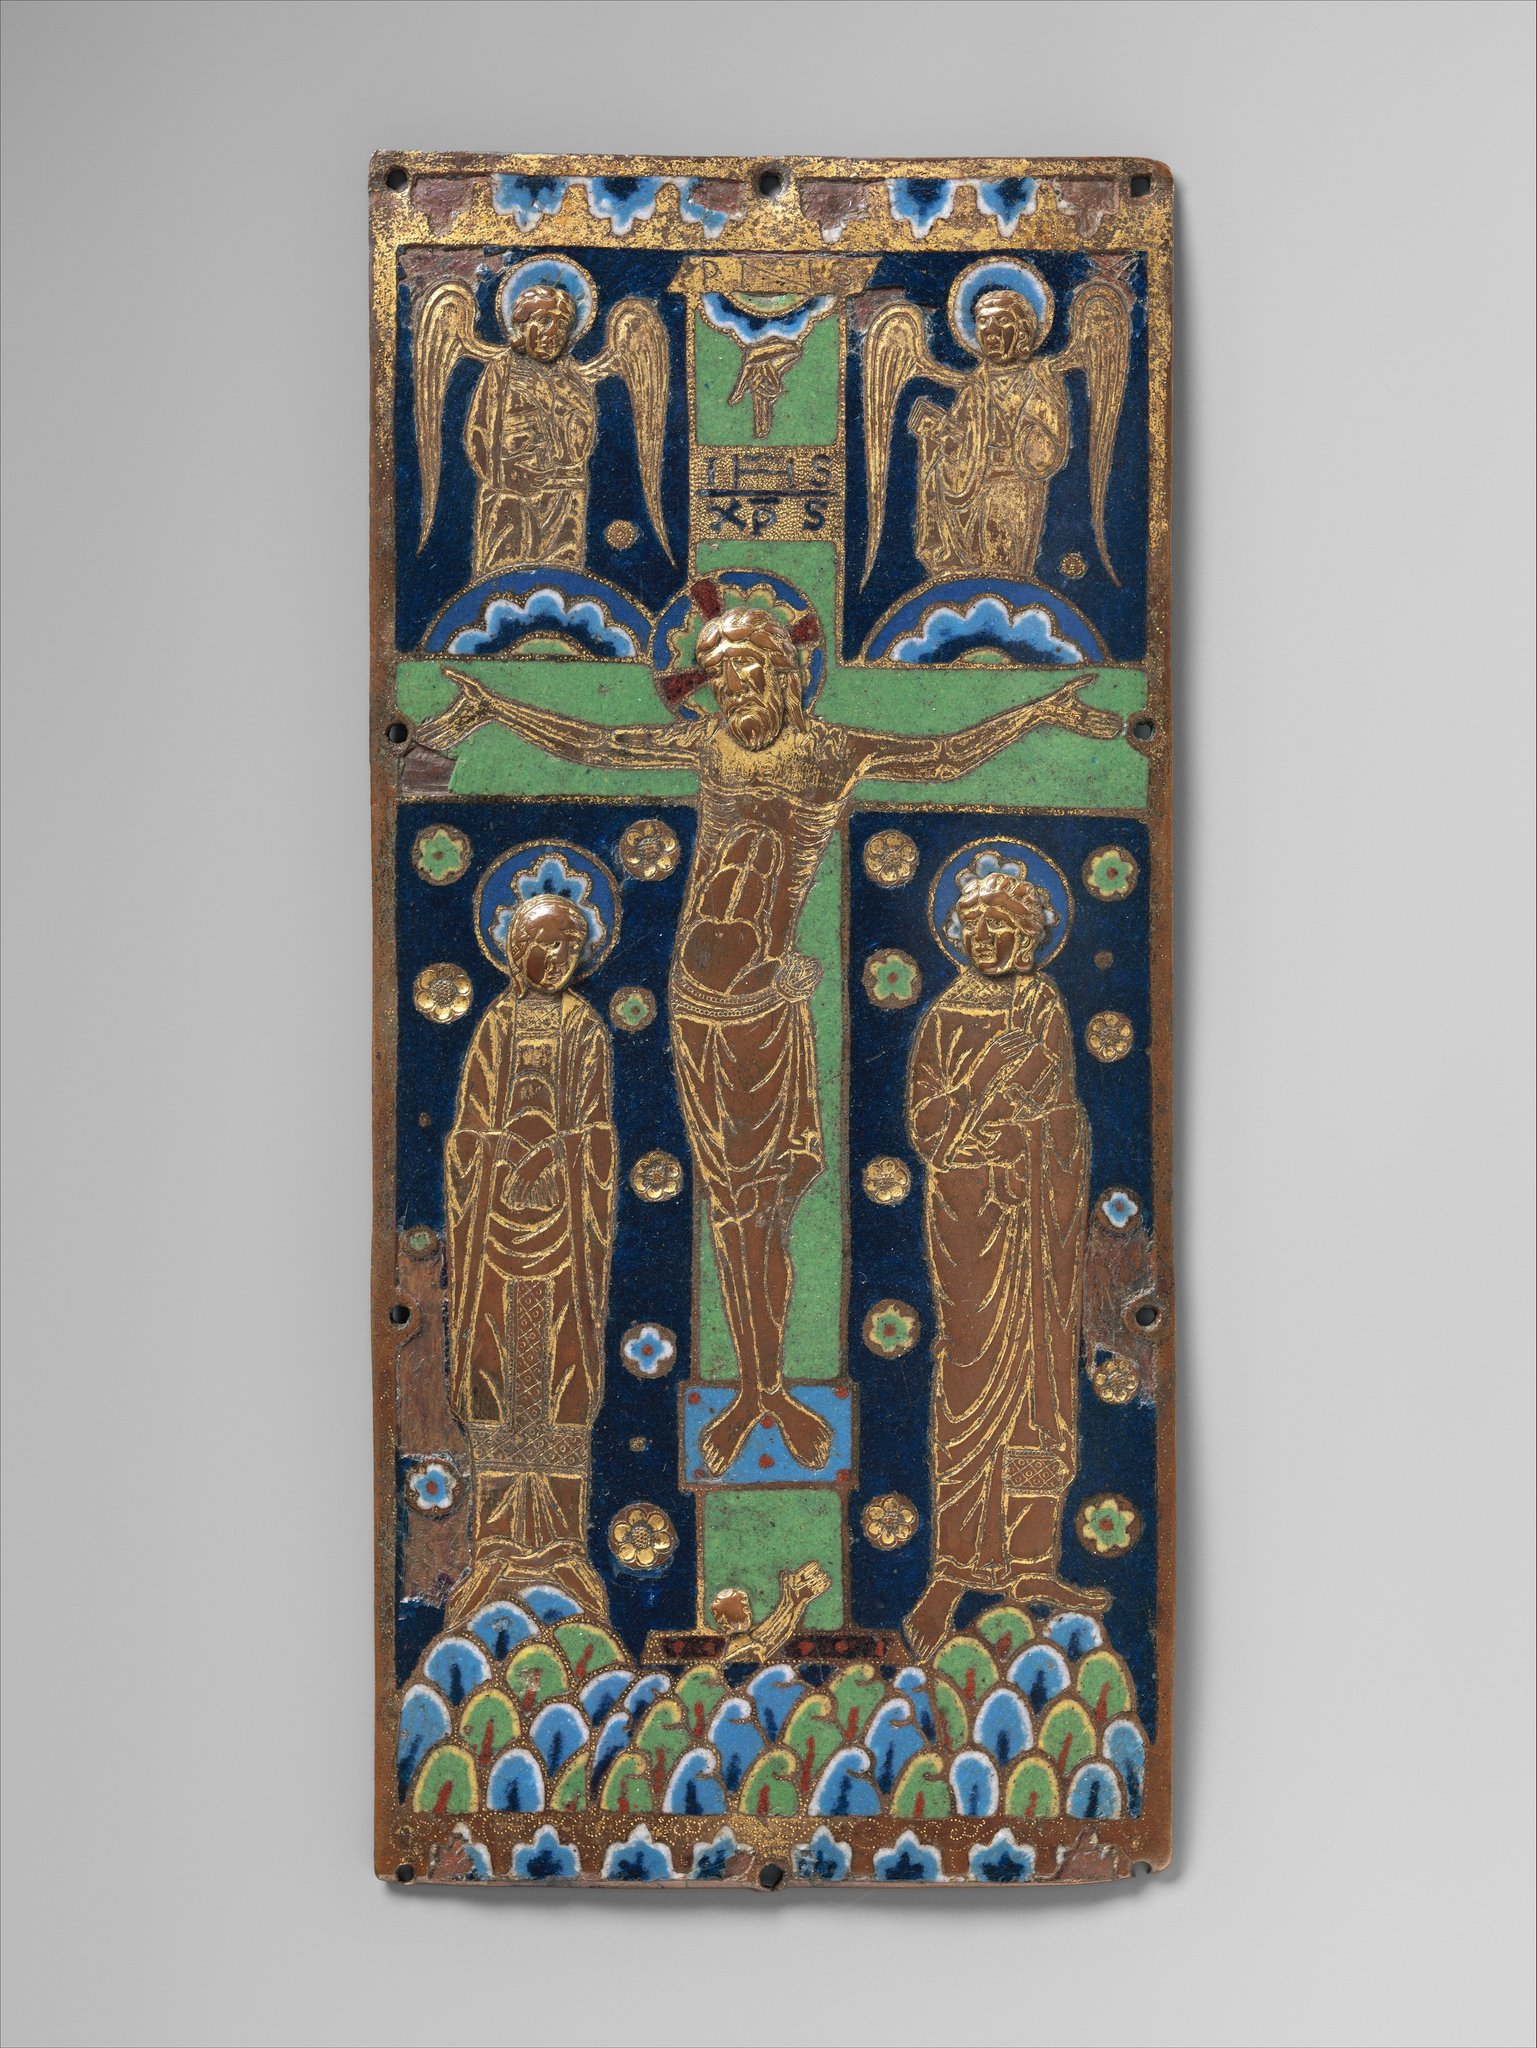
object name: plaque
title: Book Cover Plaque with the Crucifixion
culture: french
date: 1190-1200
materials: copper, enamel, gilt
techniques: enamel, chasing, engraving, repoussé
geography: france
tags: angels,christ,virgin mary,saint john